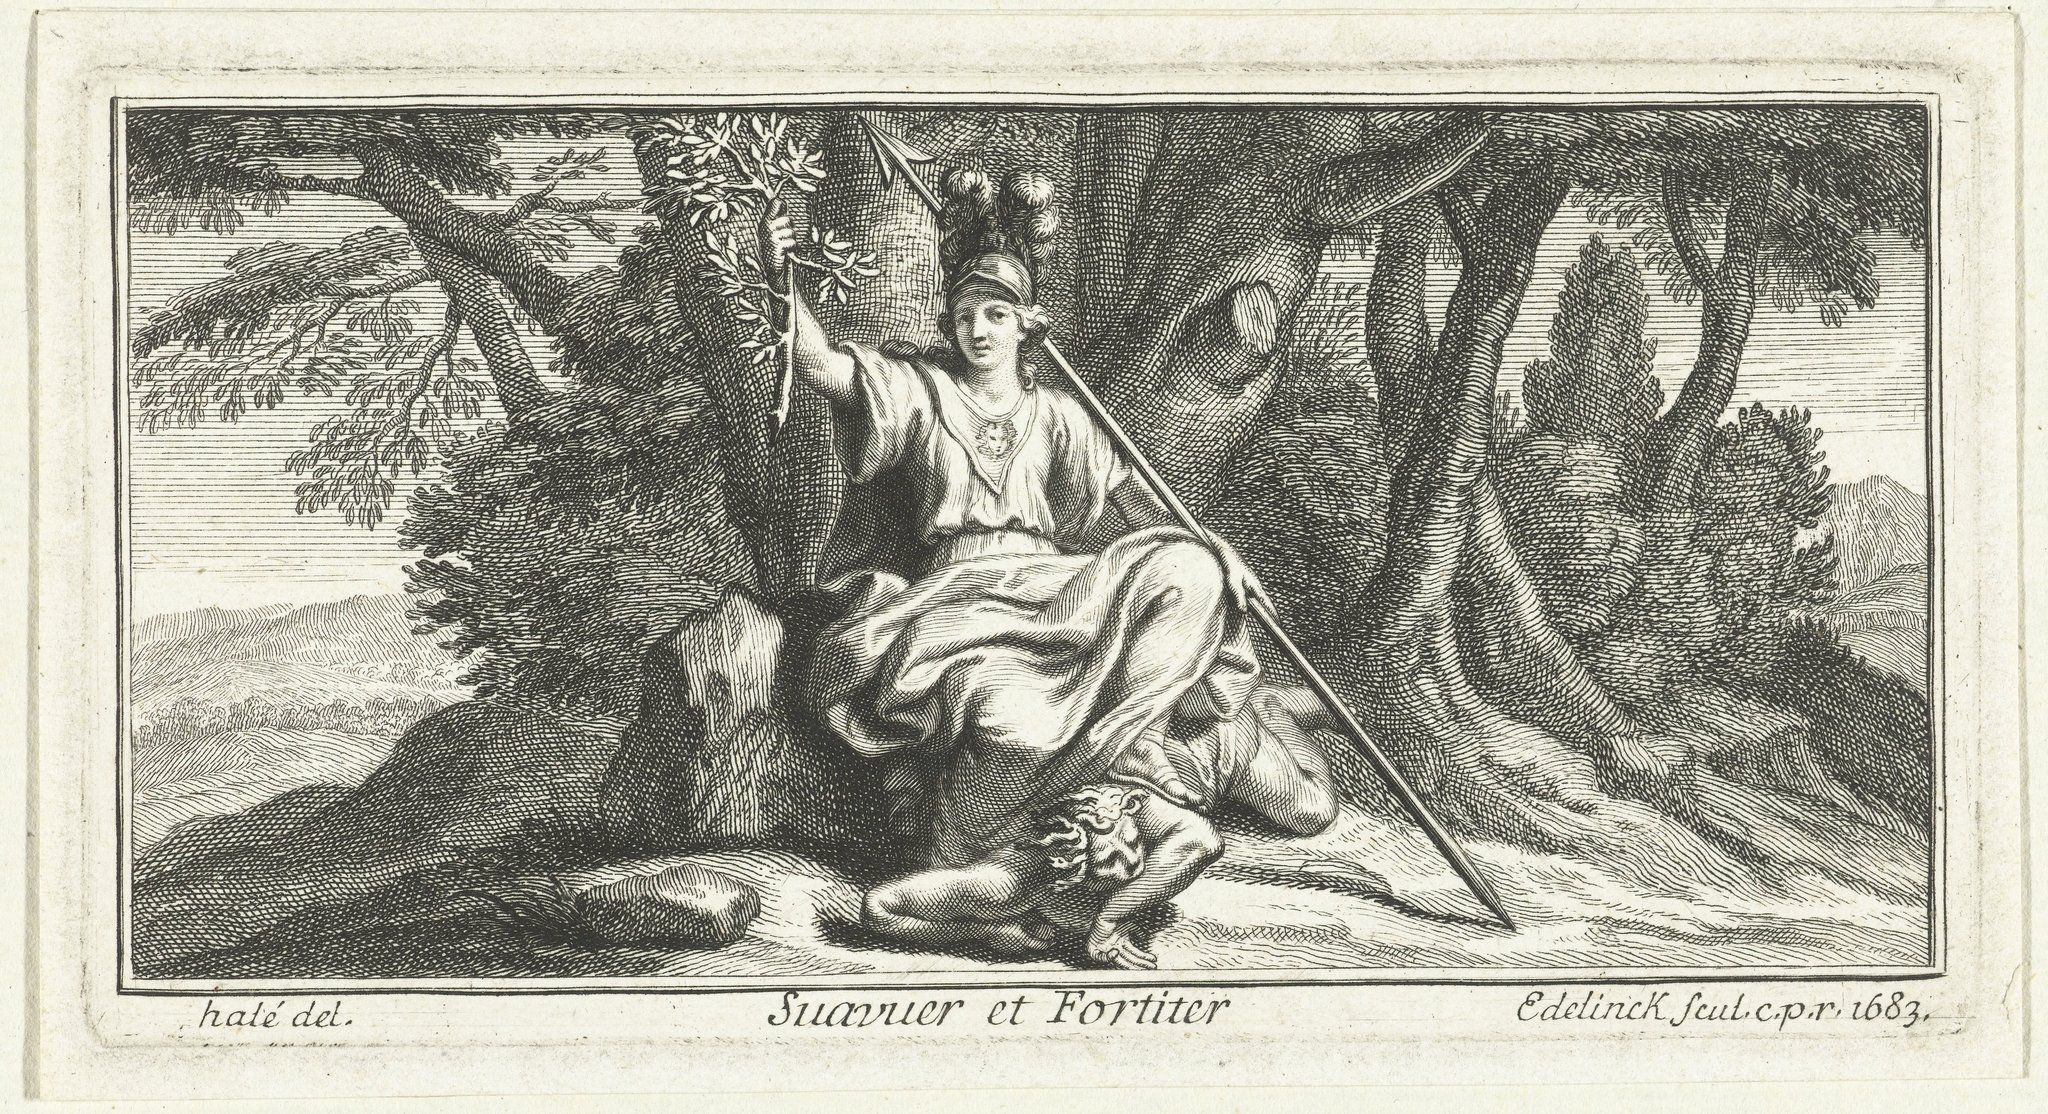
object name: print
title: Bellona overwint Afgunst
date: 1683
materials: paper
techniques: engraving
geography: france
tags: envy; 'invidia' (ripa) ~ personification of one of the seven deadly sins, bellona (enyo)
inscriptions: collector's mark: Lugt 240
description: Bellona met speer en olijventak zit op de overwonnen personificatie van de Afgunst, herkenbaar aan het slangenhaar.